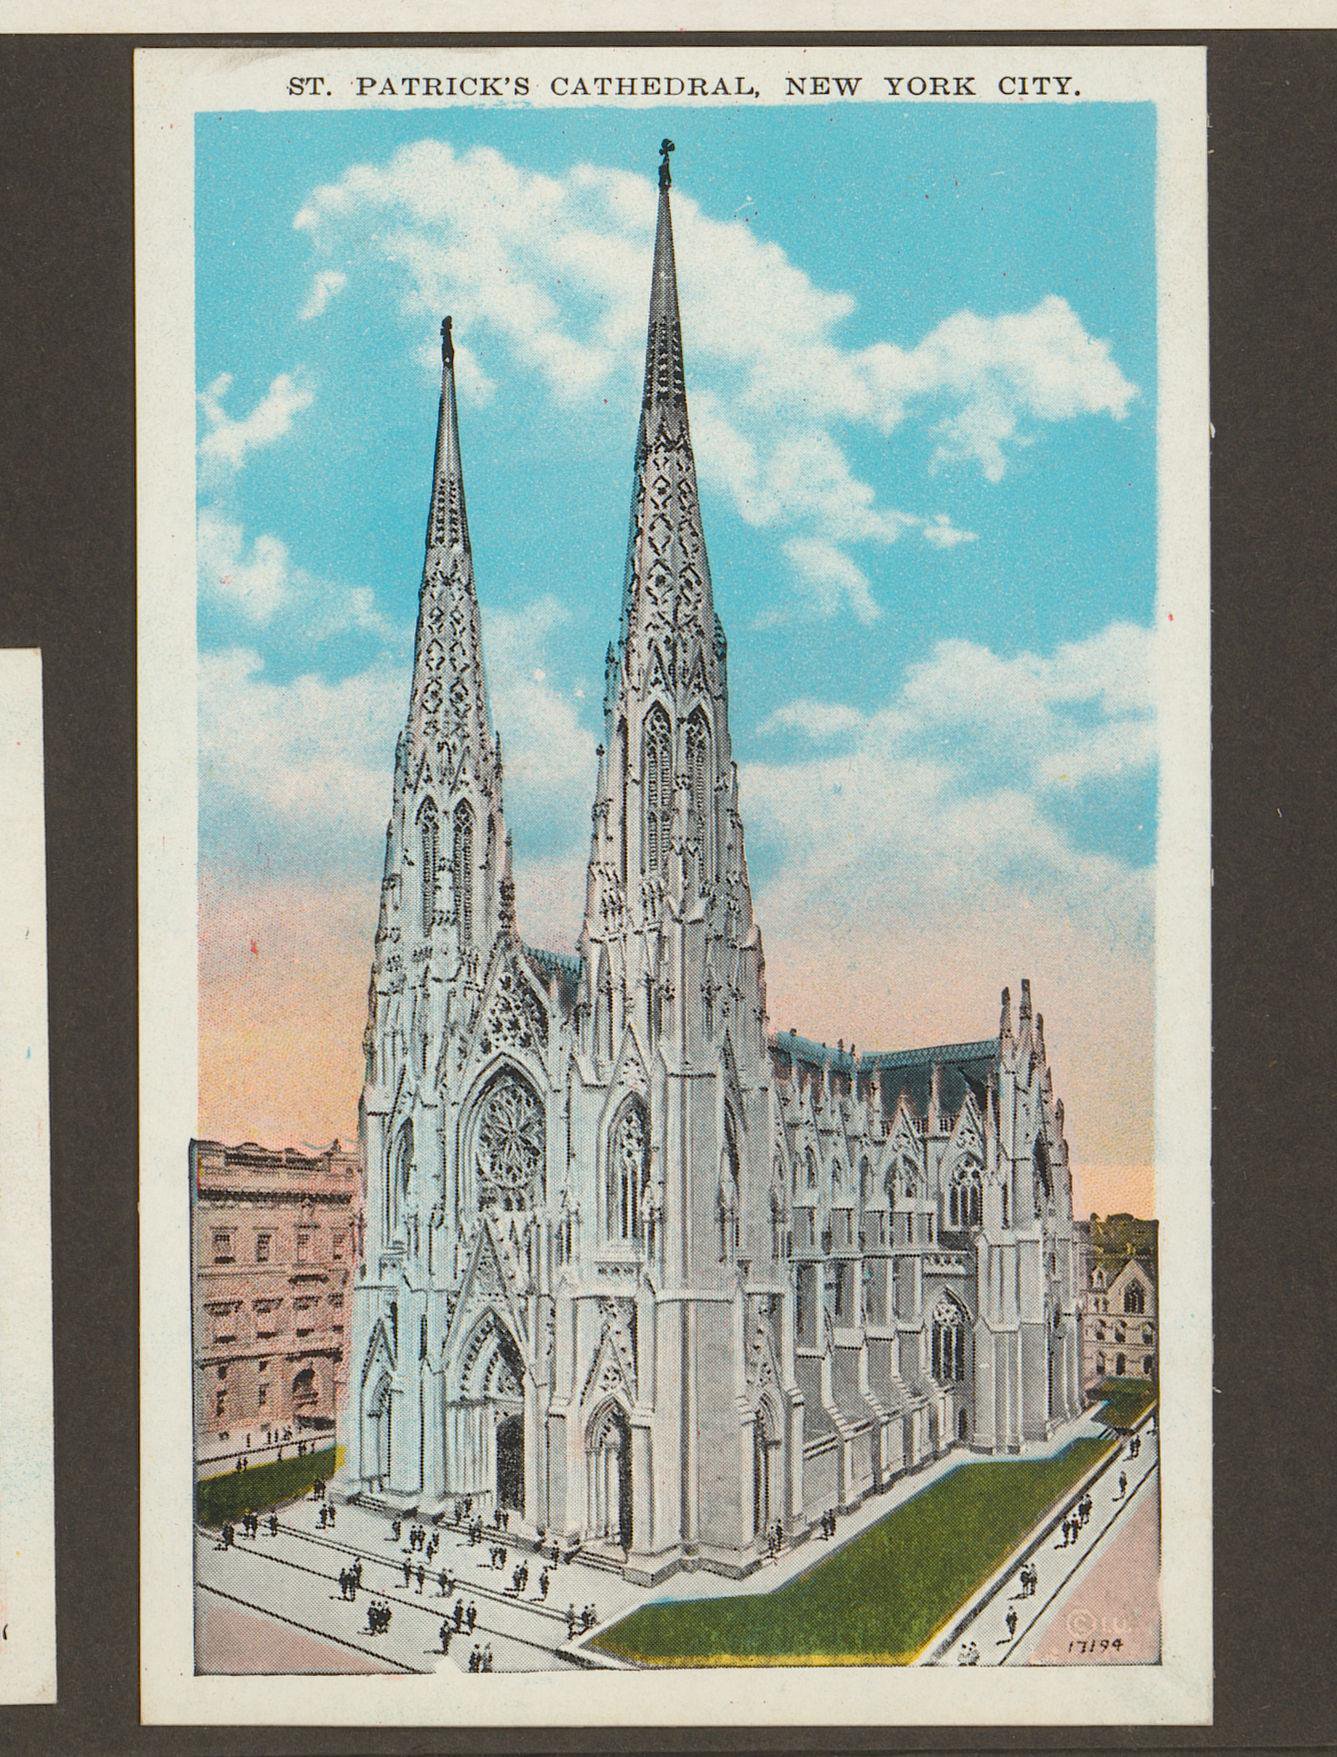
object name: photomechanical print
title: St. Patrick's cathedral, New York City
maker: Anonymous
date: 1928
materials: paper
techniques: four-color autotype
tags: church (exterior), new york (city)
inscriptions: inscription: ‘©I. U.’, number: ‘17194’